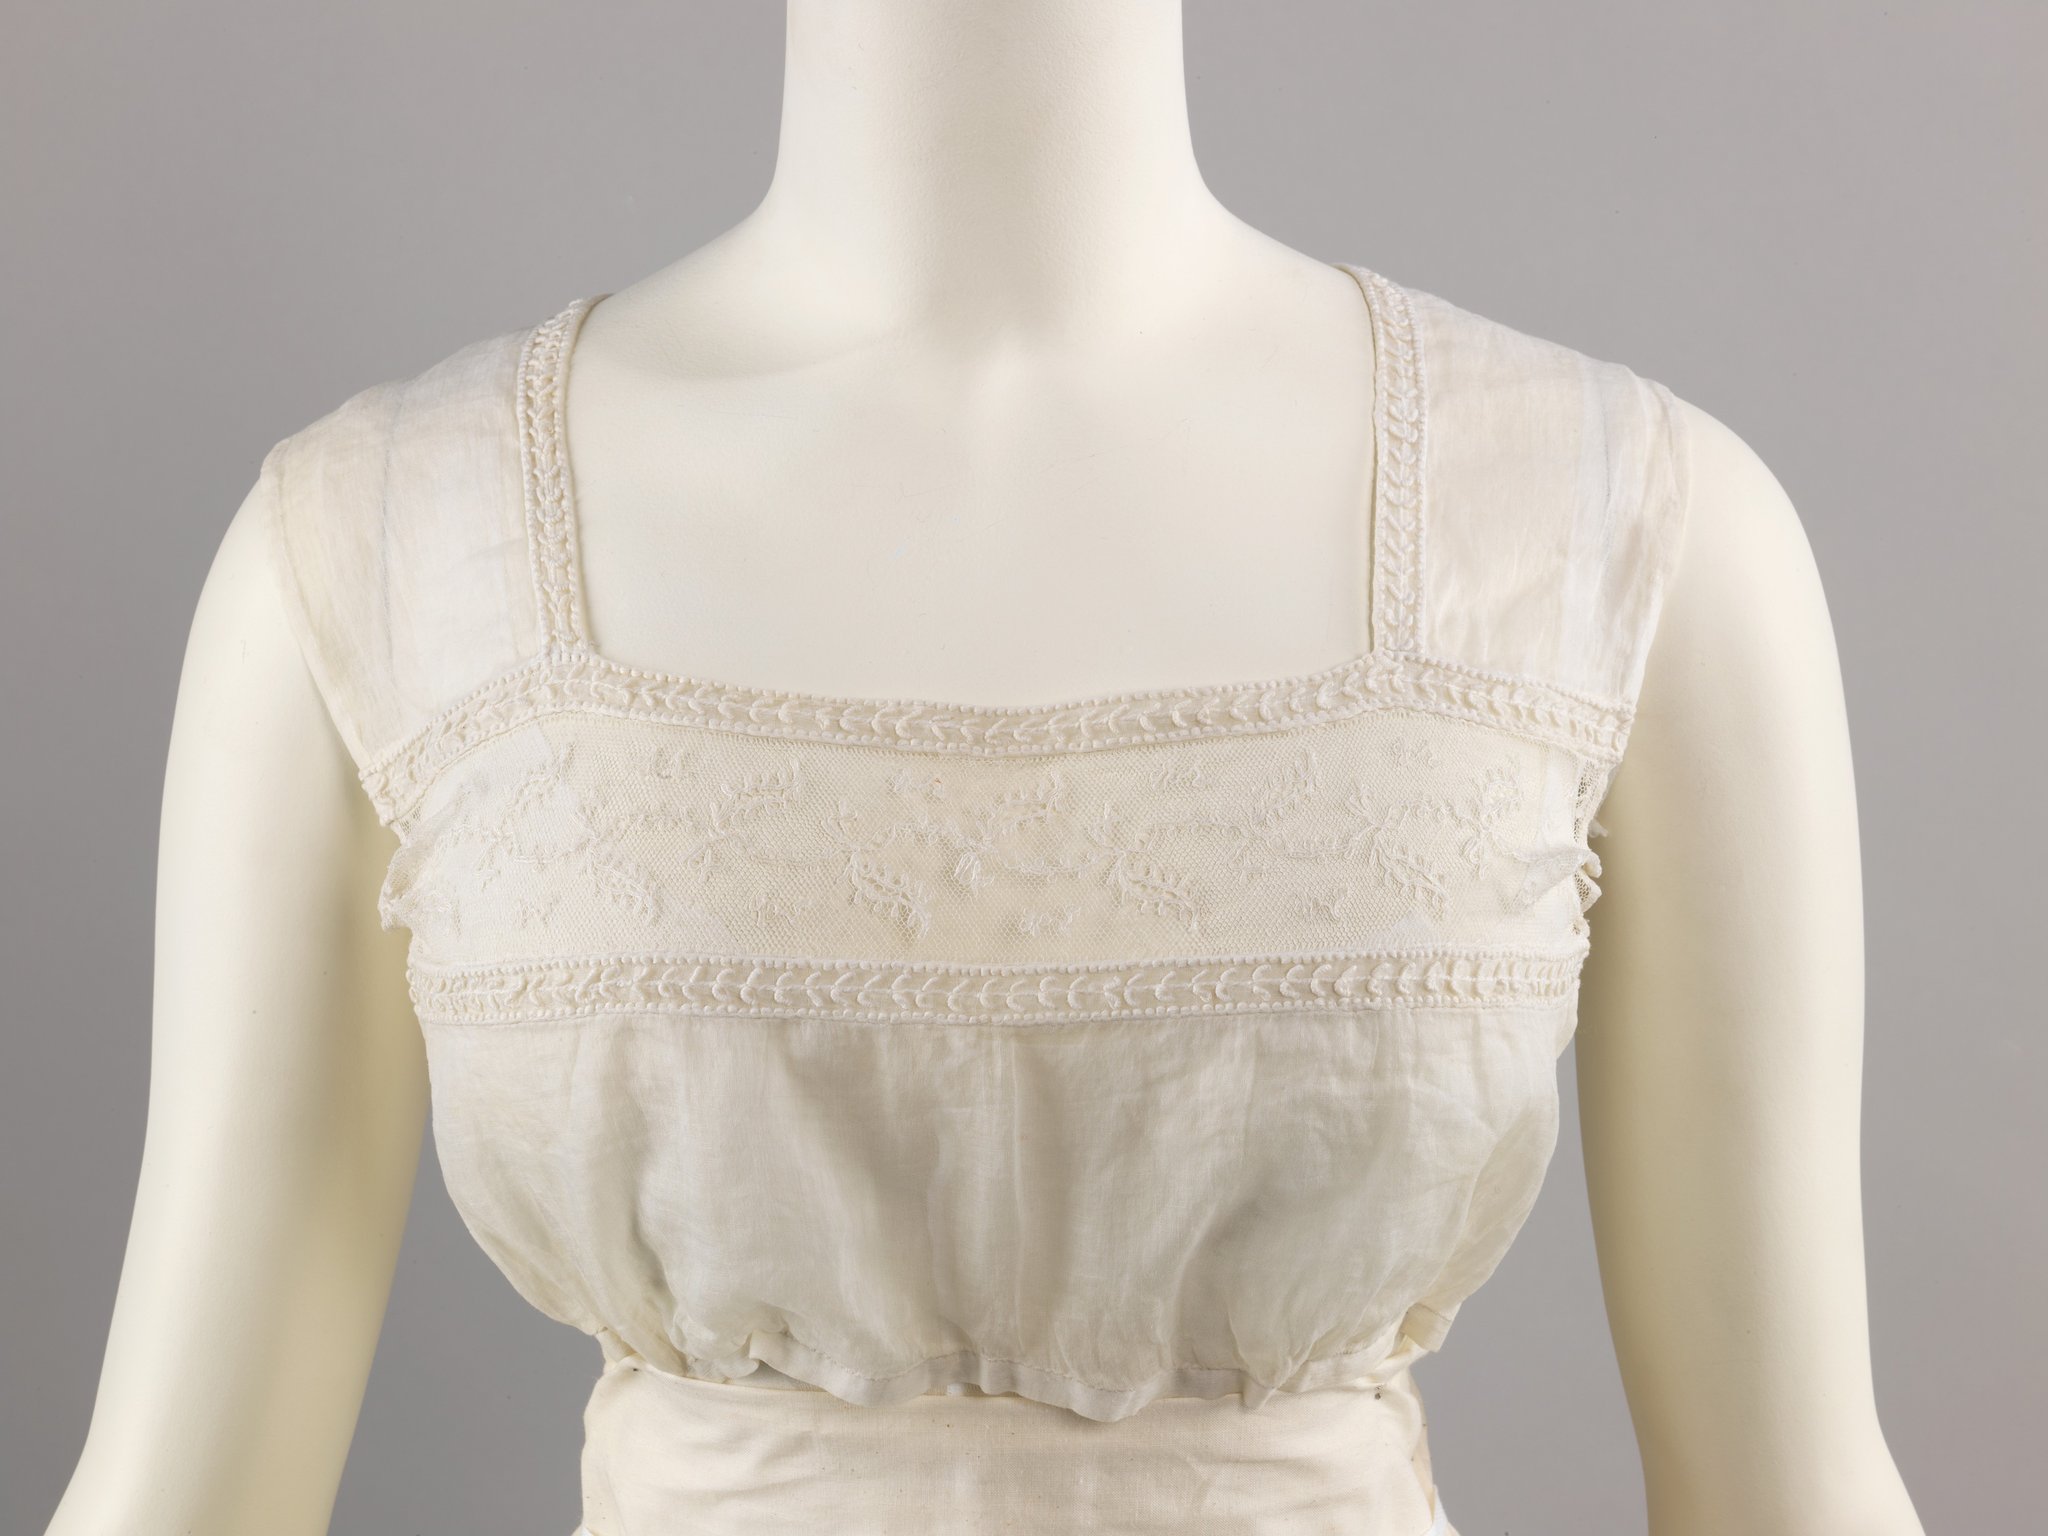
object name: tucker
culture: french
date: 1820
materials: cotton